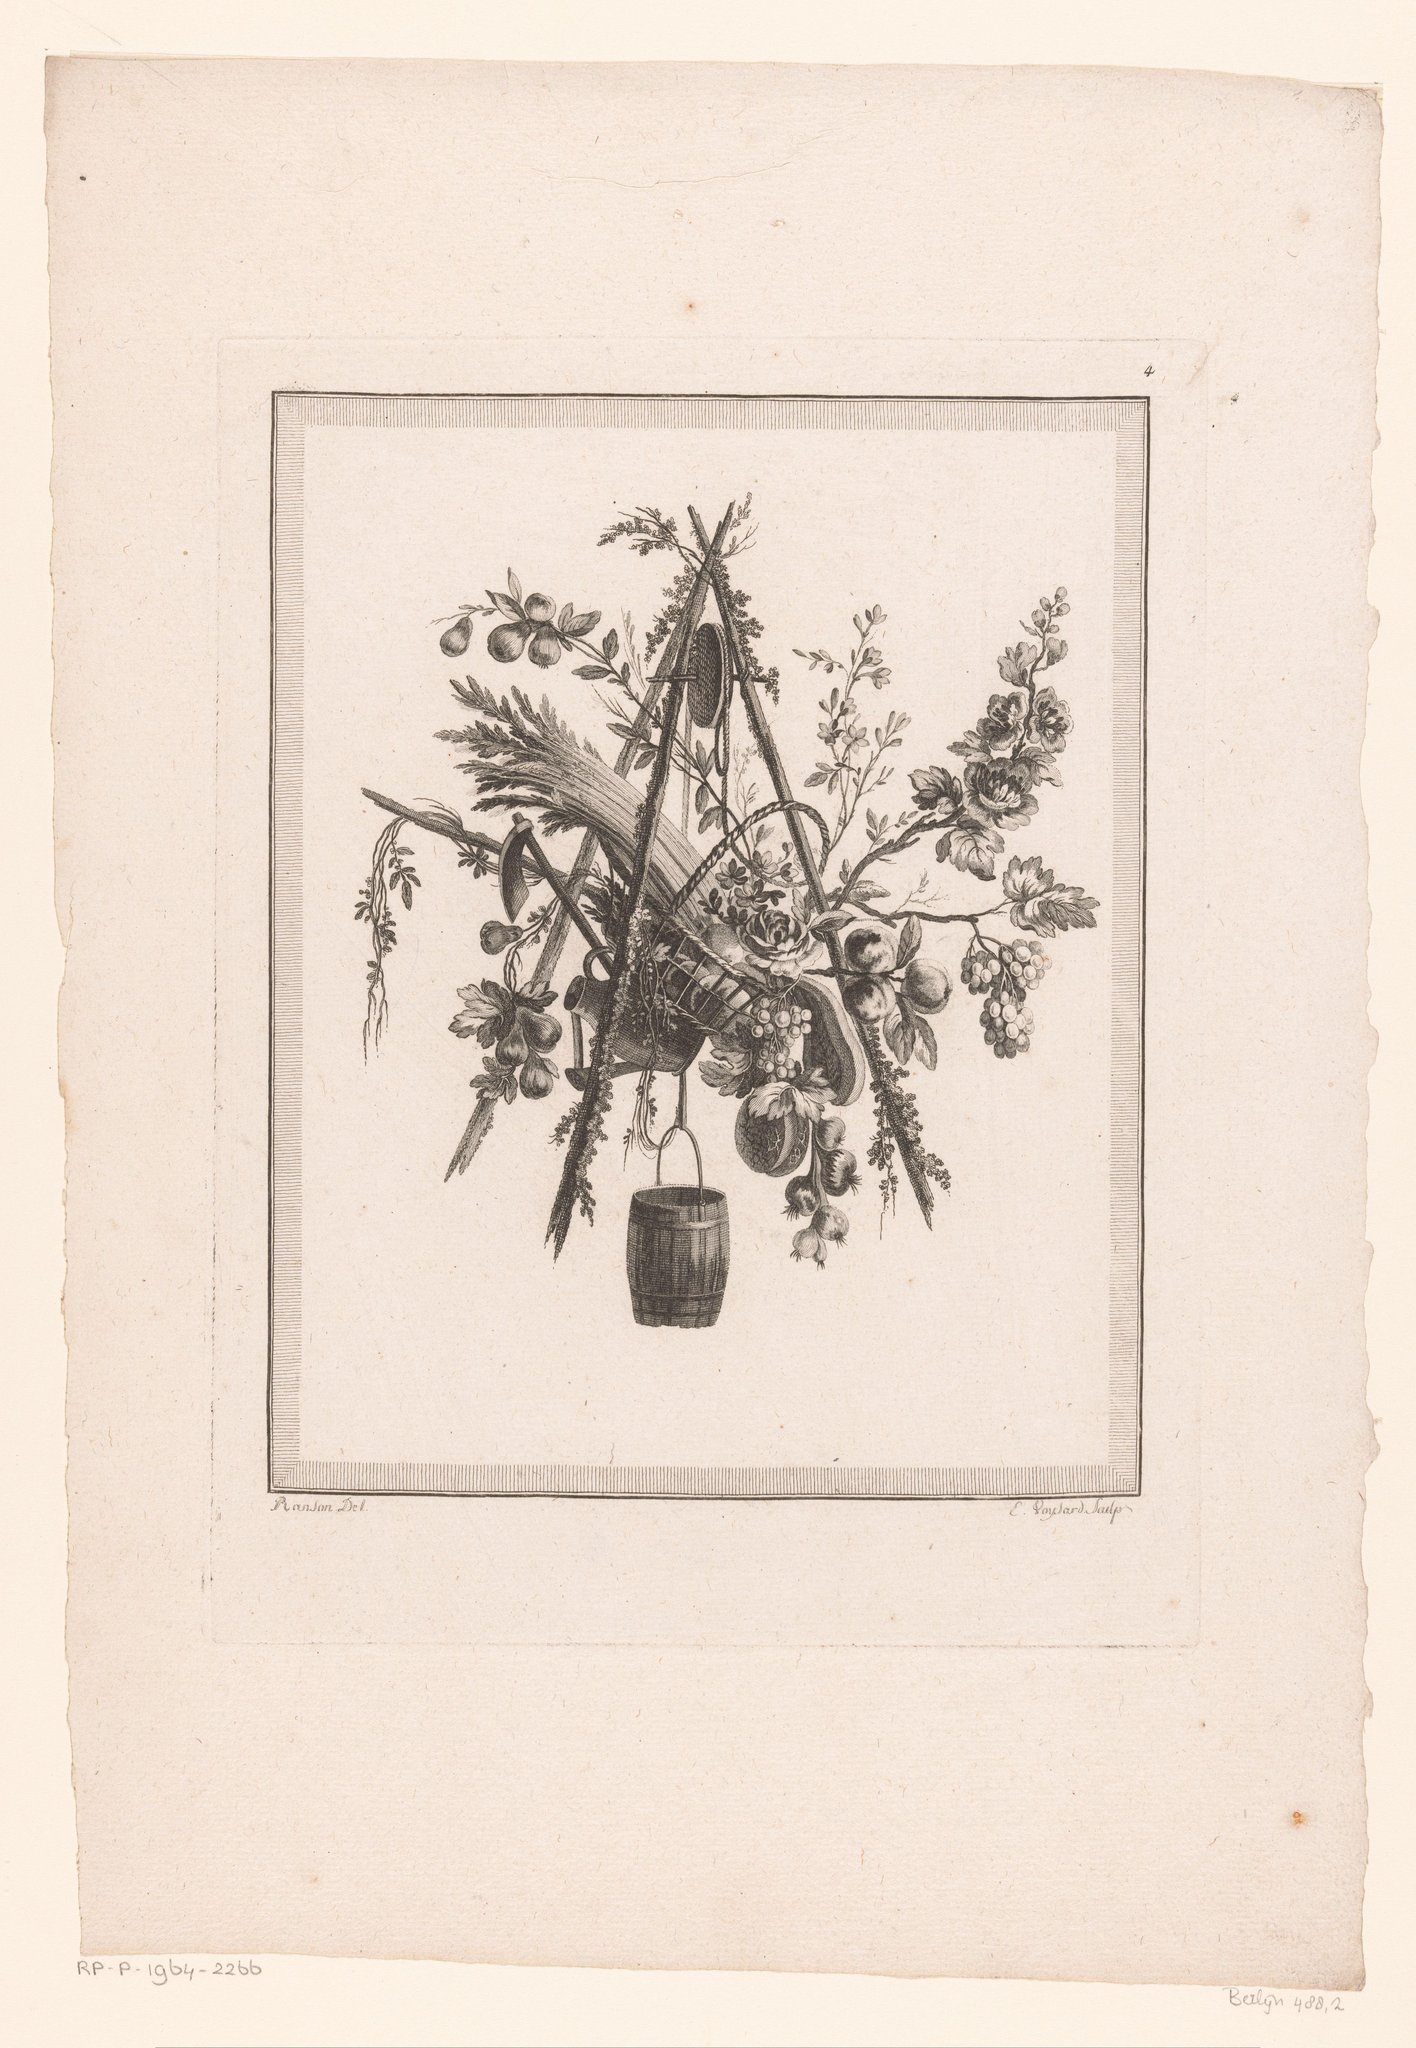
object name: print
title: Trofee met katrol, bloemen en fruit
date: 1778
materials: paper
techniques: etching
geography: paris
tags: flowers, trophy, i.e.: decorative arrangement of symbolic or typical objects ~ ornament, vertical transport, hoisting (industrial processes), fruits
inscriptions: collector's mark: Lugt 2760, collector's mark: Lugt 2228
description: Een trofee met een katrol, bloemen, fruit, korenaren, een mand, een houweel, een gieter en een emmer.